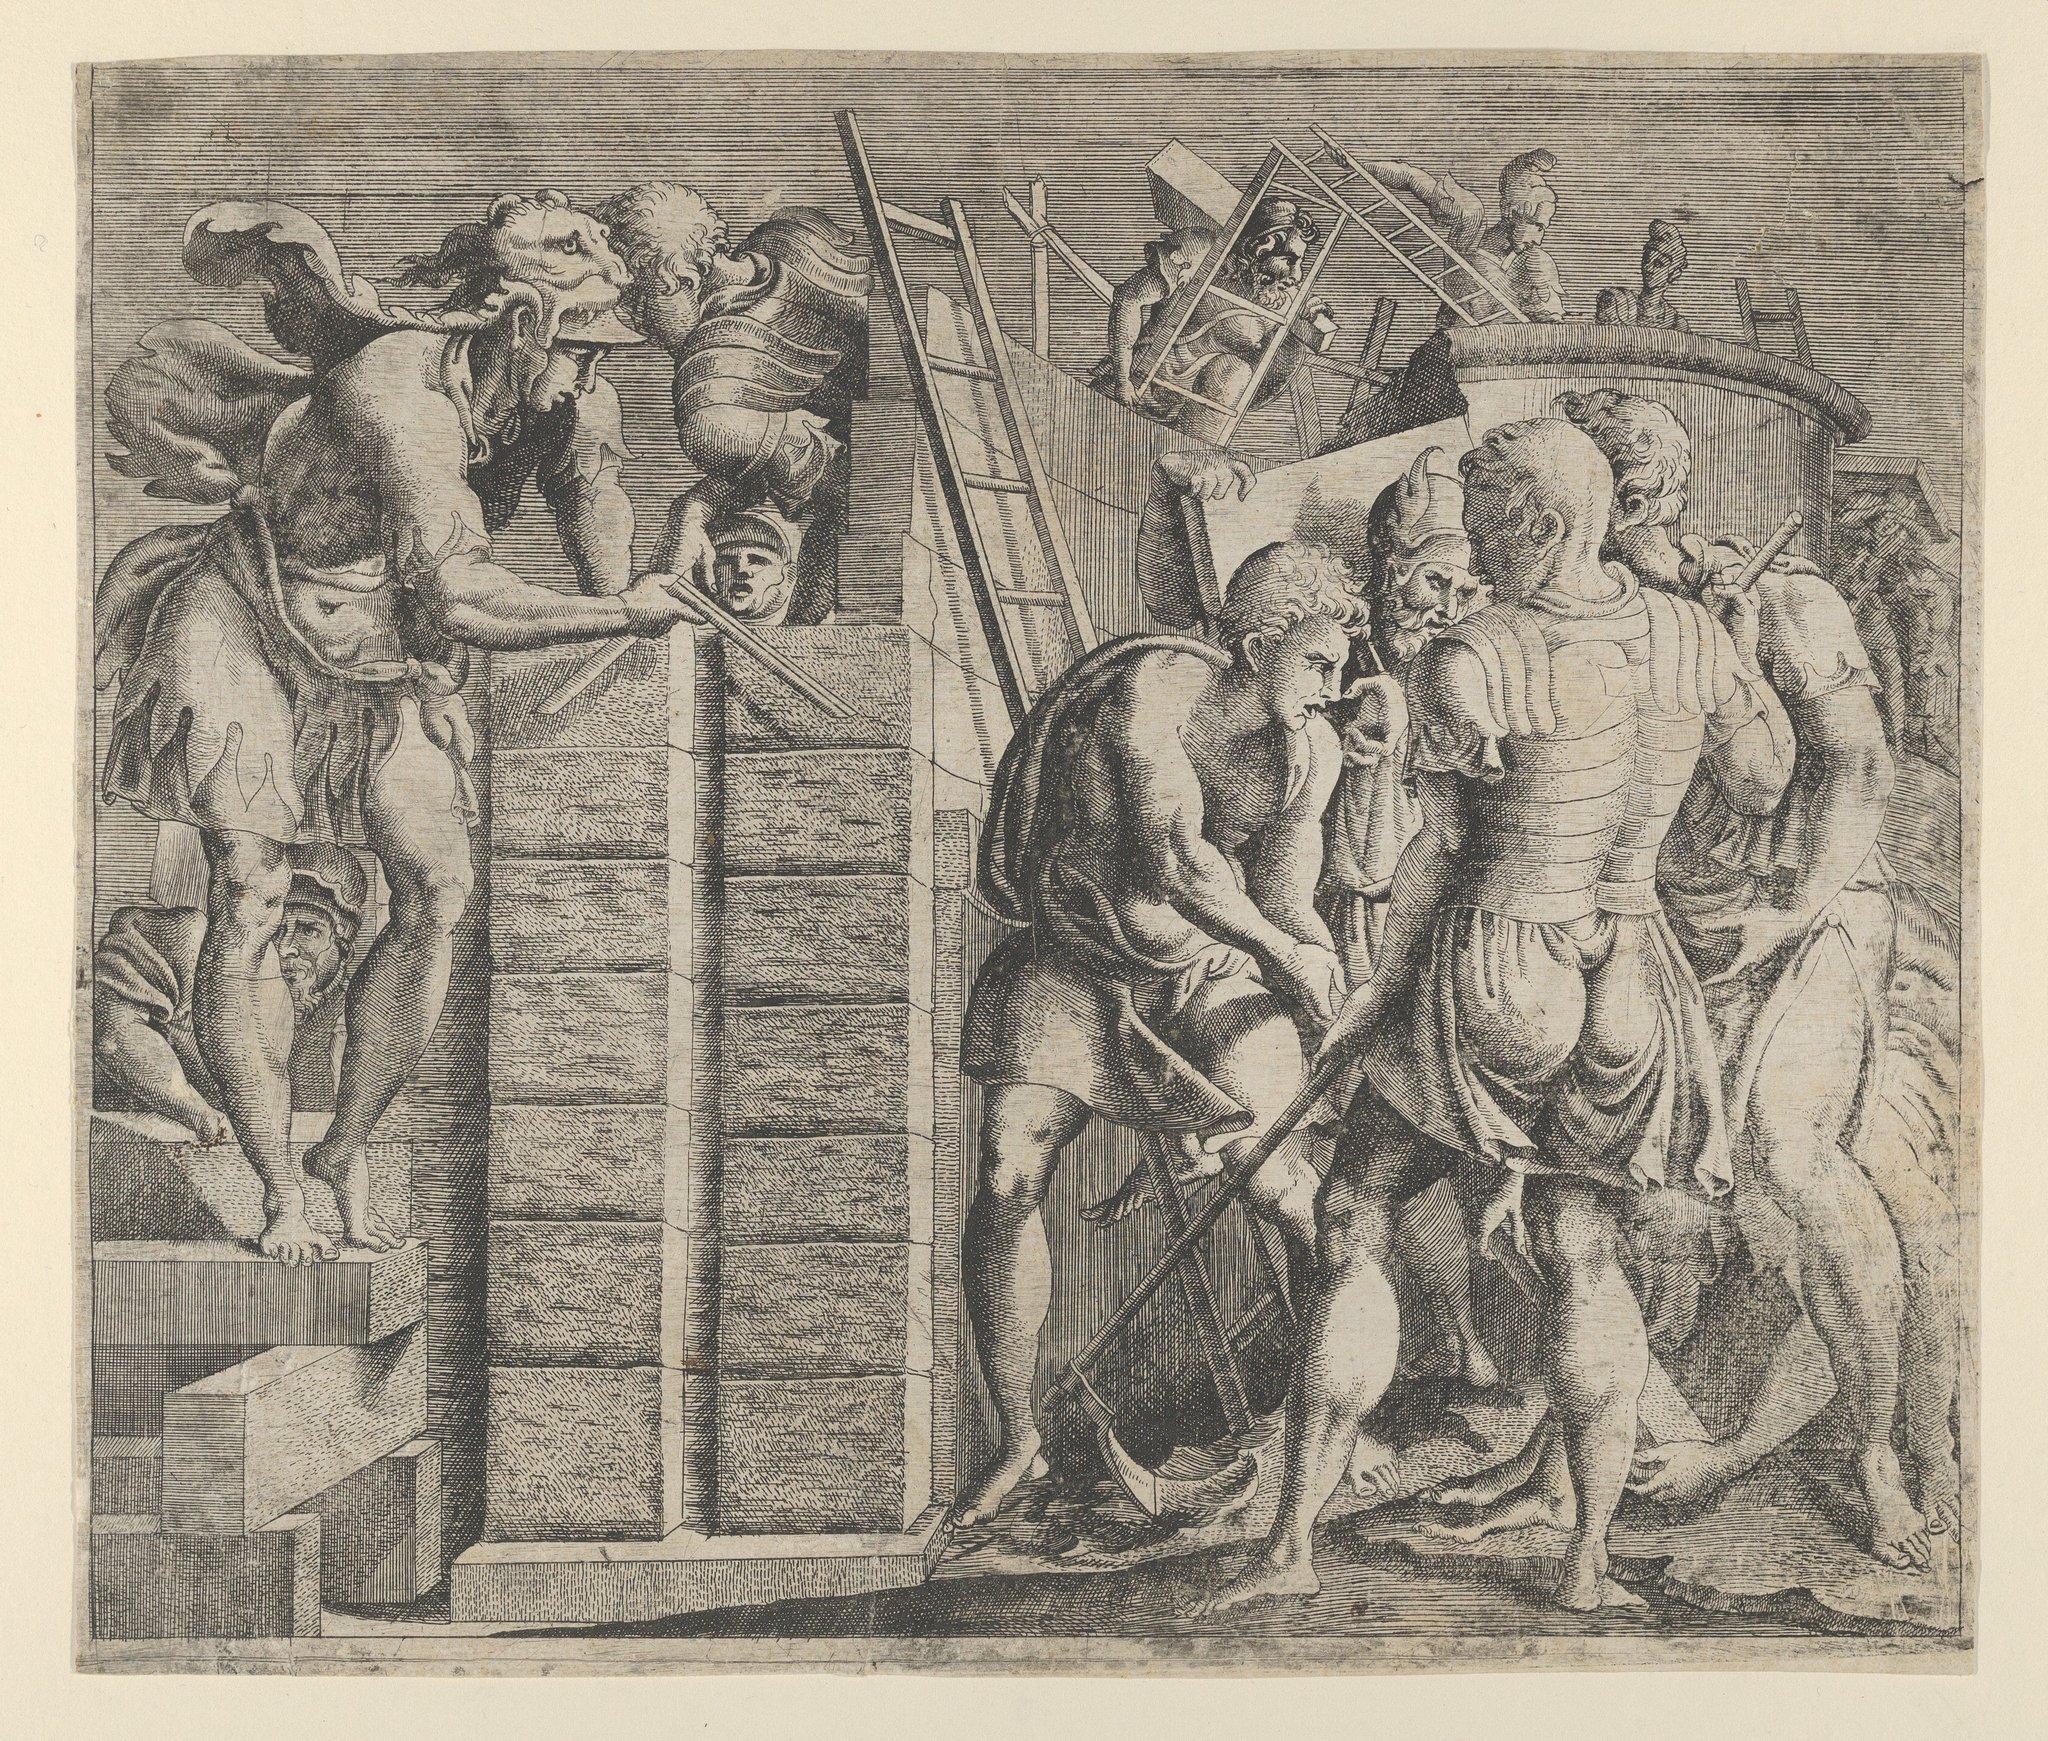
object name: print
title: Cadmus Building Thebes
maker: anonymous, french, school of fontainebleau, 16th century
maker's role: artist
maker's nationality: french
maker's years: 1500-1600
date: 1542-1545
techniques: etching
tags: kings,men,working,ladders